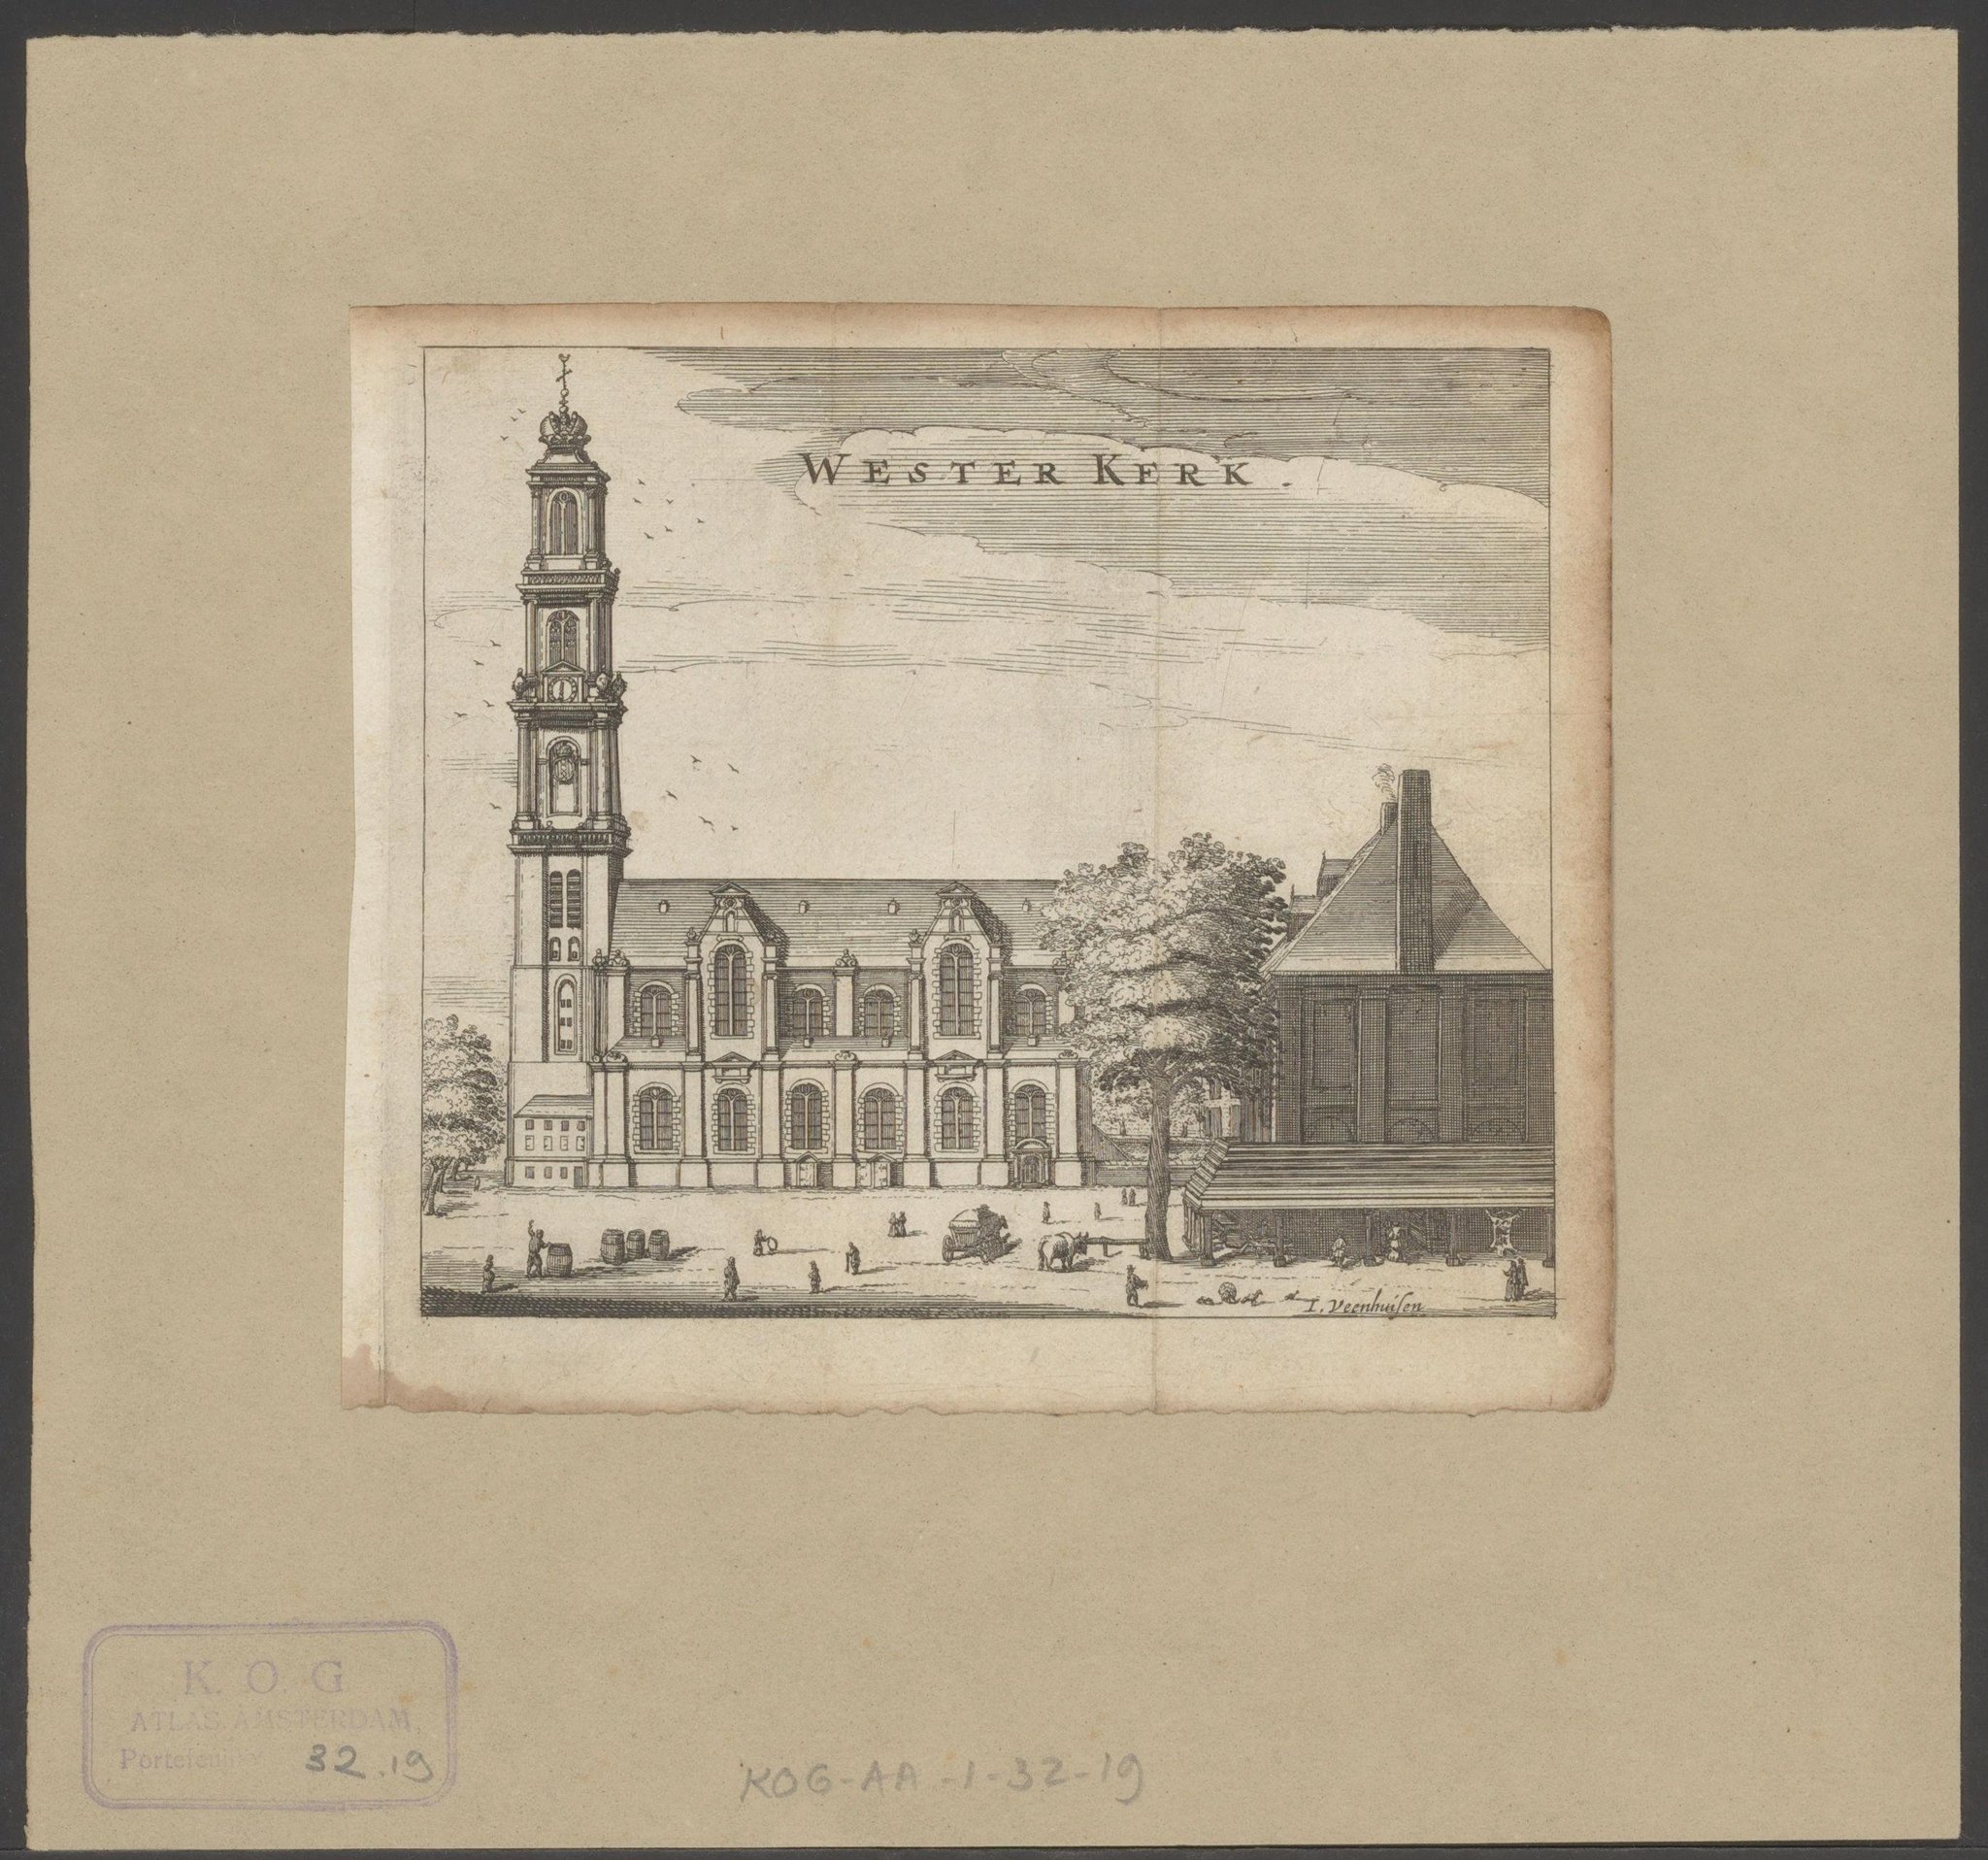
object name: book illustration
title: Wester Kerk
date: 1664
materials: paper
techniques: engraving, etching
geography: amsterdam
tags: church (exterior), village street (+ city(-scape) with figures, staffage)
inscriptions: collector's mark: ‘32.19’ Lugt 1641b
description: Huidige staat van prent ook gebruikt in: Fockens, Melchior. Beschrijving Der wijdt-vermaarde Koop-stadt Amstelredam, Van haar eerste beginselen, zedert den Jare 1203. oude Voorrechten, verscheyde Vergrootingenoude Voor-rechten, en verscheyde Vergrootingen (…). 3de druk. Amsterdam: Marcus Willemsz. Doornick, 1664. En in: Zesen, Philipp von. Beschrybung der Weidtberuhmde Kauf-Stadt Amstelredam / Beschreibung der Stadt Amsterdam darinnen von derselben ersten ursprunge bis auf gegenwartigen zustand (…). Amsterdam: Marcus Willemsz. Doornick, 1664. Eerste bekende staat van prent (rechtsboven genummerd: 228) ook gebruikt in: Fockens, Melchior. Beschrijvinge Der wijdt-vermaarde Koop-stadt Amstelredam, Van hare eerste beginselen, oude Voor-rechten, en verscheyde Vergrootingen (…). 1ste druk. Amsterdam: Marcus Willemsz. Doornick, 1662. En in: Fockens, Melchior. Beschrijvinge Der wijdt-vermaarde Koop-stadt Amstelredam, Van hare eerste beginselen, oude Voor-rechten, en verscheyde Vergrootingen (…). 2e druk. Amsterdam: Marcus Willemsz. Doornick, 1662. Derde bekende staat (met toevoeging Franse titel) ook gebruikt in: Domselaer, Tobias en Isaac Commelin. Beschryvinge van Amsterdam : haar eerste oorspronk uyt den huyze der heeren van Aemstel en Aemstellant (…). 6 dln. Amsterdam: Marcus Willemsz van Doornick, 1665. Vierde bekende staat (rechtsboven genummerd: 13) ook gebruikt in verschillende latere zeventiende- en achttiende-eeuwse publicaties.